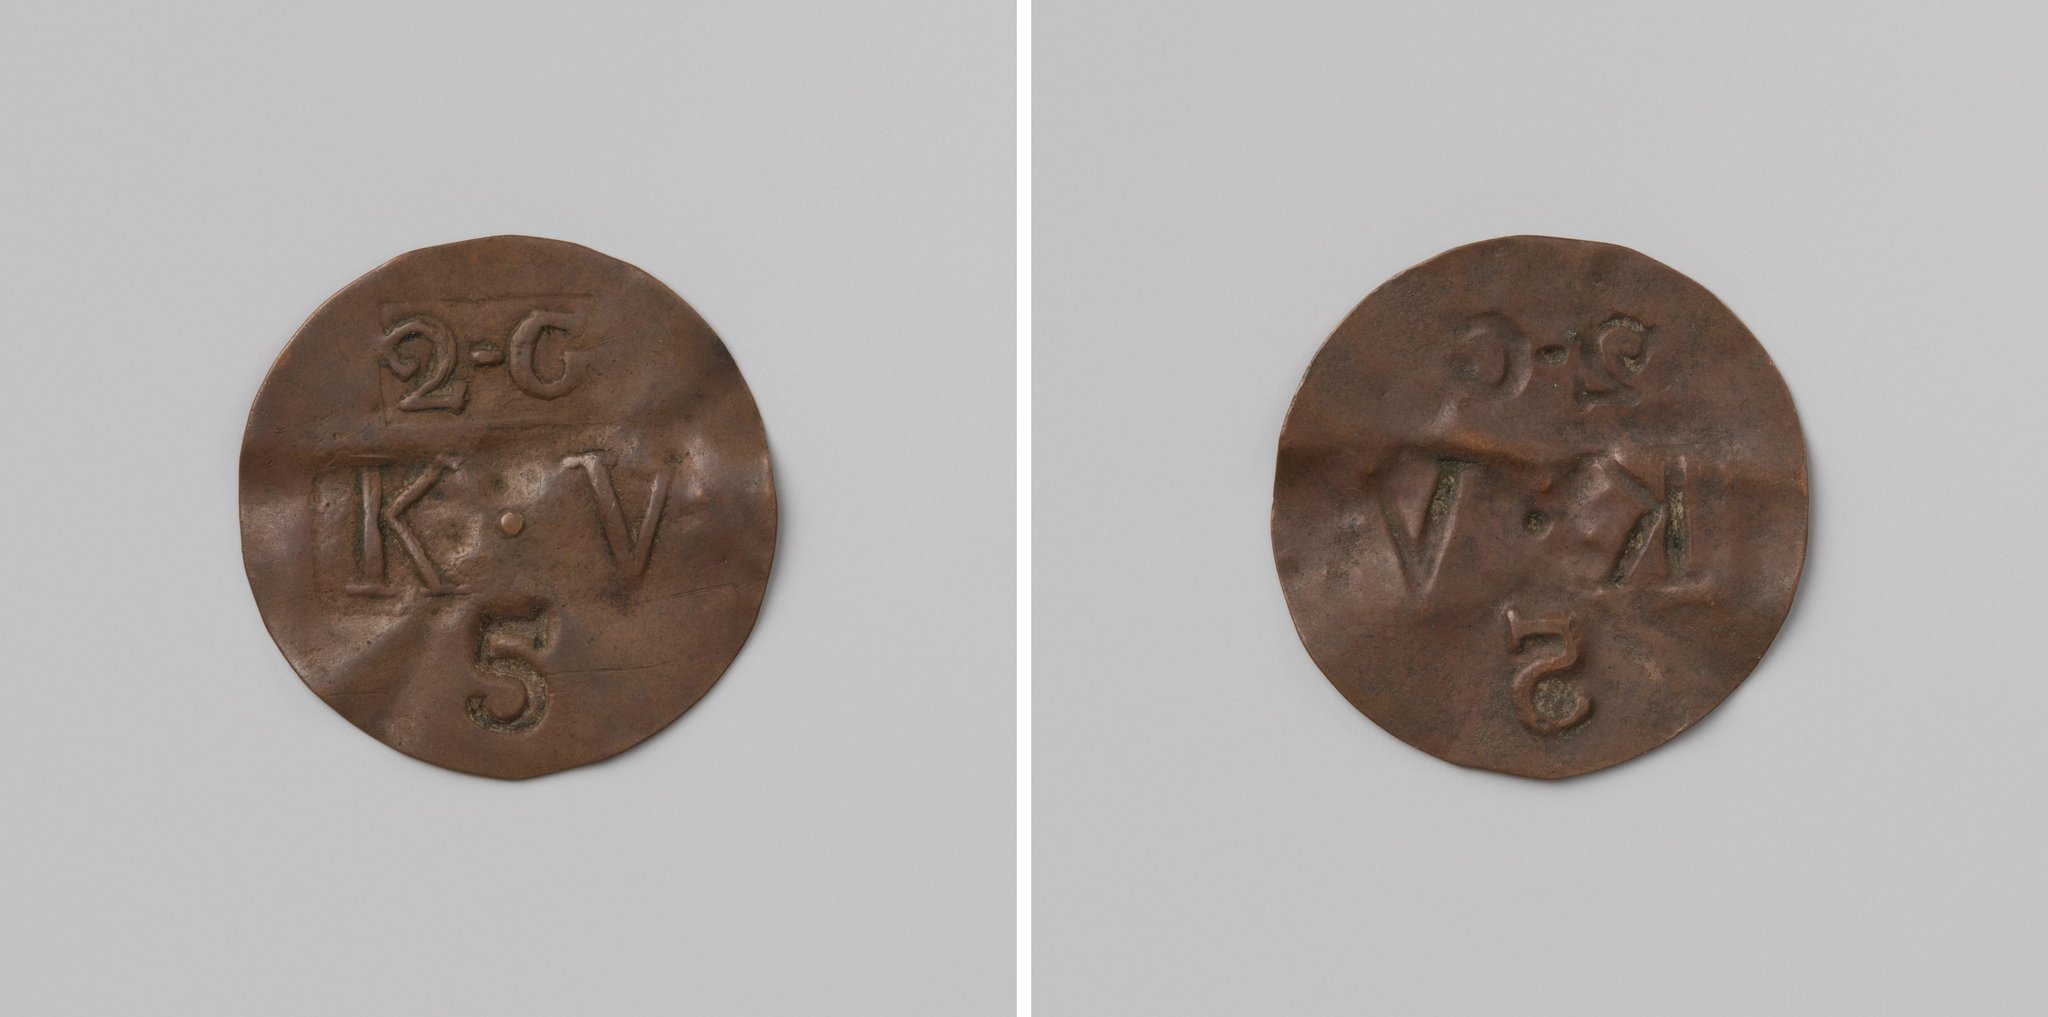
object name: monetary token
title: Tweede gesticht van de kolonie Veenhuizen, huismunt geslagen op last van de Maatschappij van Weldadigheid ter waarde van vijf cent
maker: Anonymous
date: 1818-1859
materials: copper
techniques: striking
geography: netherlands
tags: maatschappij van weldadigheid, veenhuizen